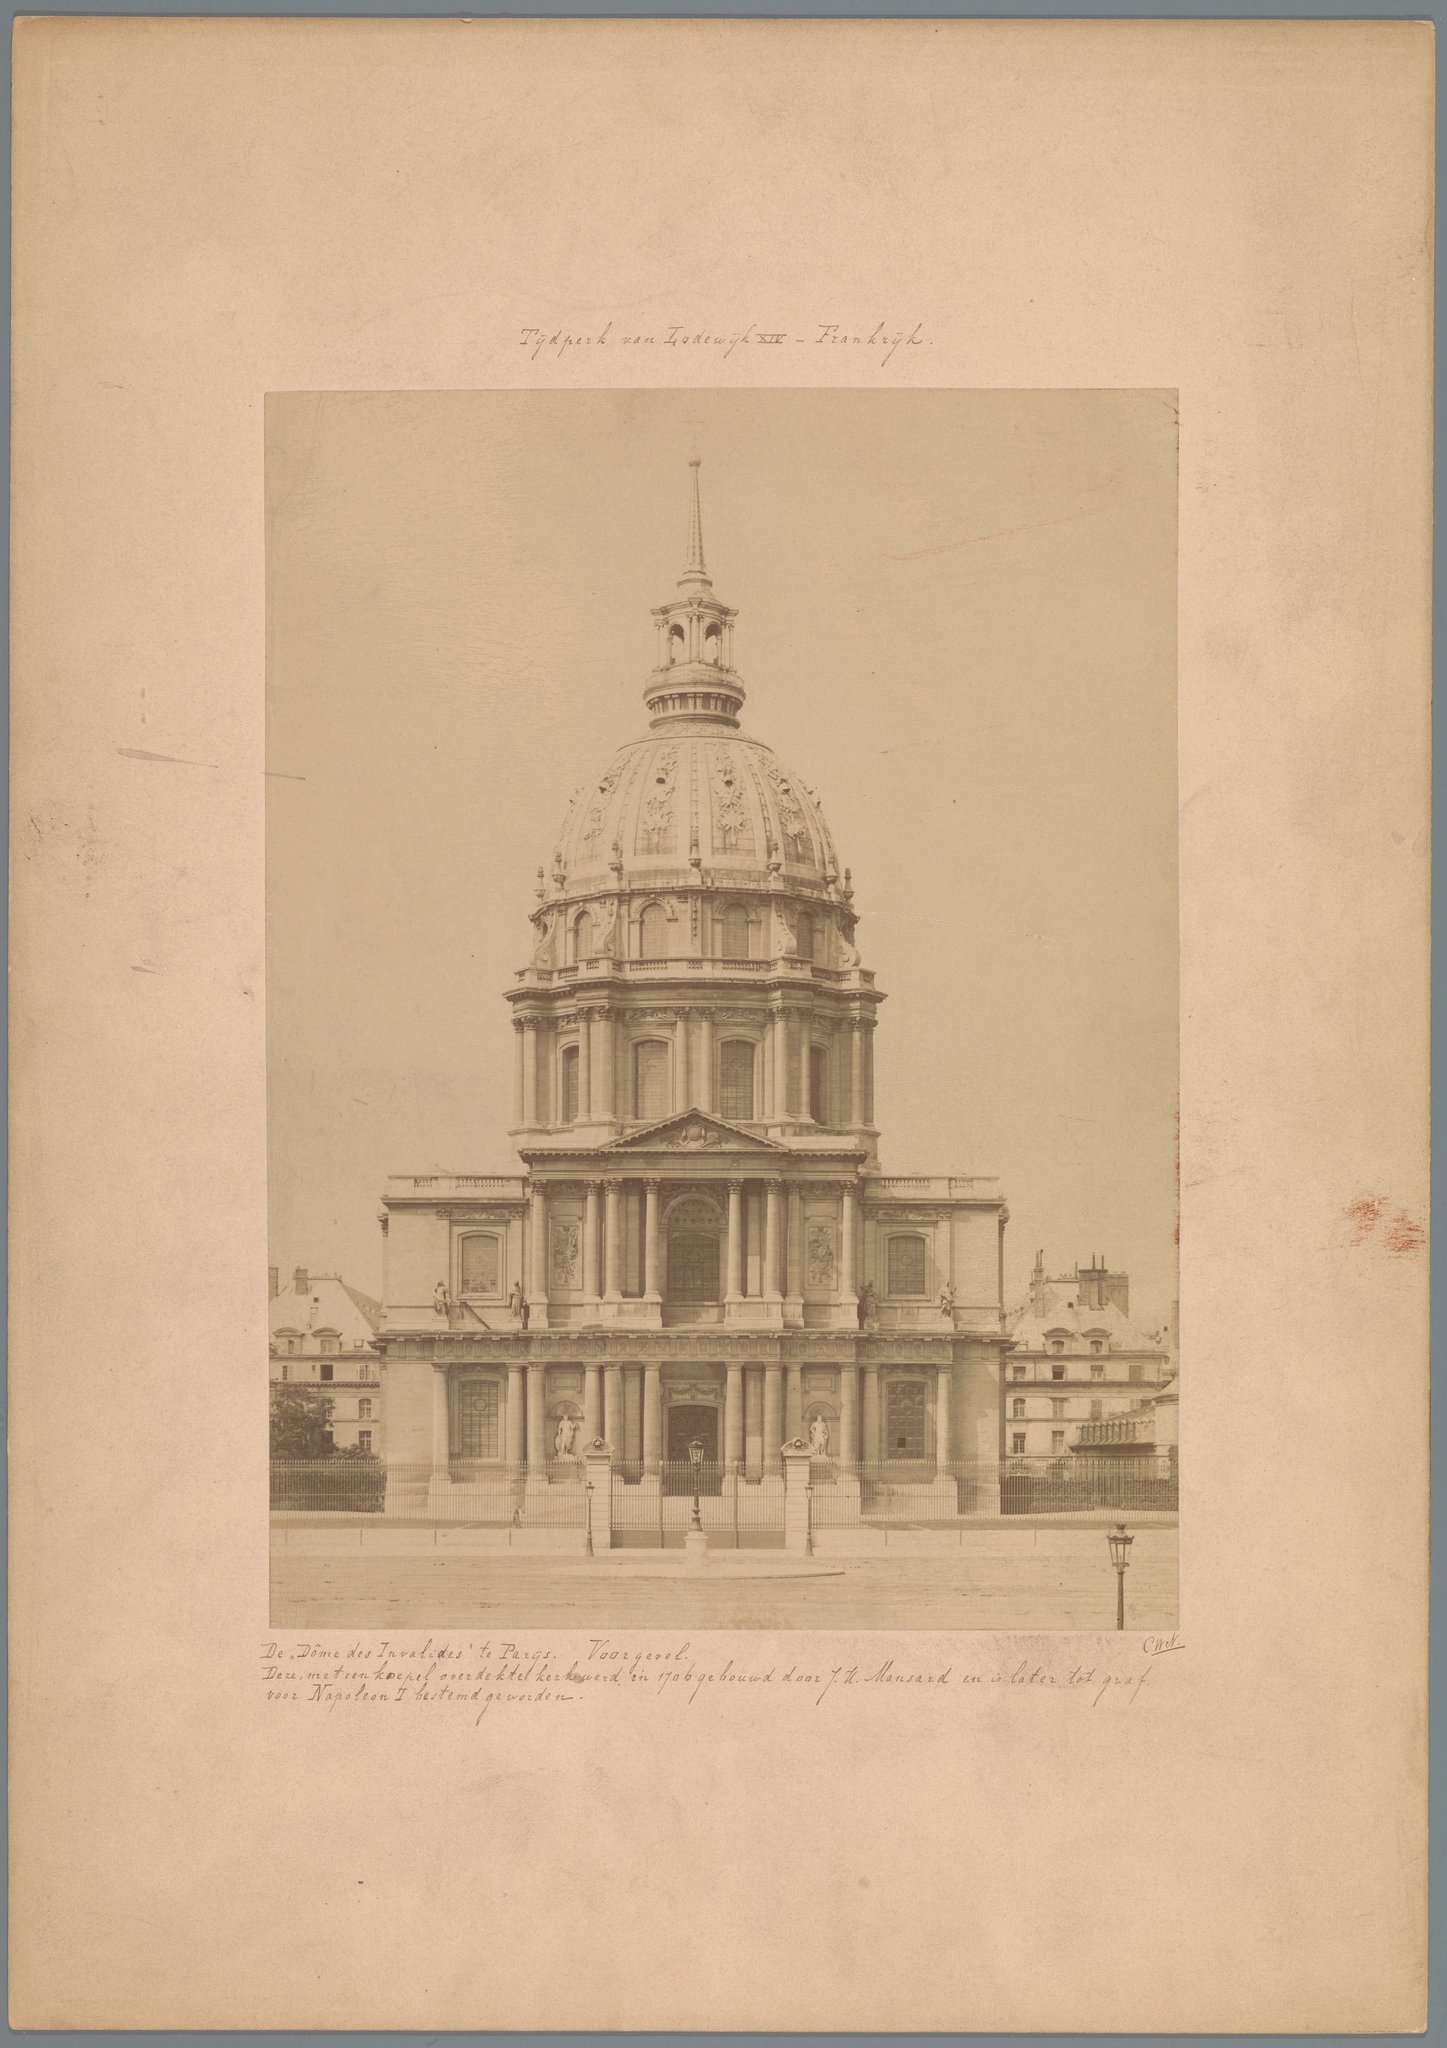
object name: photograph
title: Façade van de Dôme des Invalides te Parijs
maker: Anonymous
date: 1875-1900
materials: cardboard, photographic support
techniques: albumen print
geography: paris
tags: façade (of house or building), dome ~ architecture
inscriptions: collector's mark: ‘INSTITUUT VOOR KUNST-NIJVERHEIDSONDERWIJS GABRIËL METSUSTRAAT No. 16 AMSTERDAM’, collector's mark: ‘KUNSTNIJVERHEIDSCHOOL QUELLINUS AMSTERDAM FRANS HALSSTRAAT 14.’, inscription: ‘Tijdperk van Lodwijk XIV - Frankrijk.’, inscription: ‘CWN.’